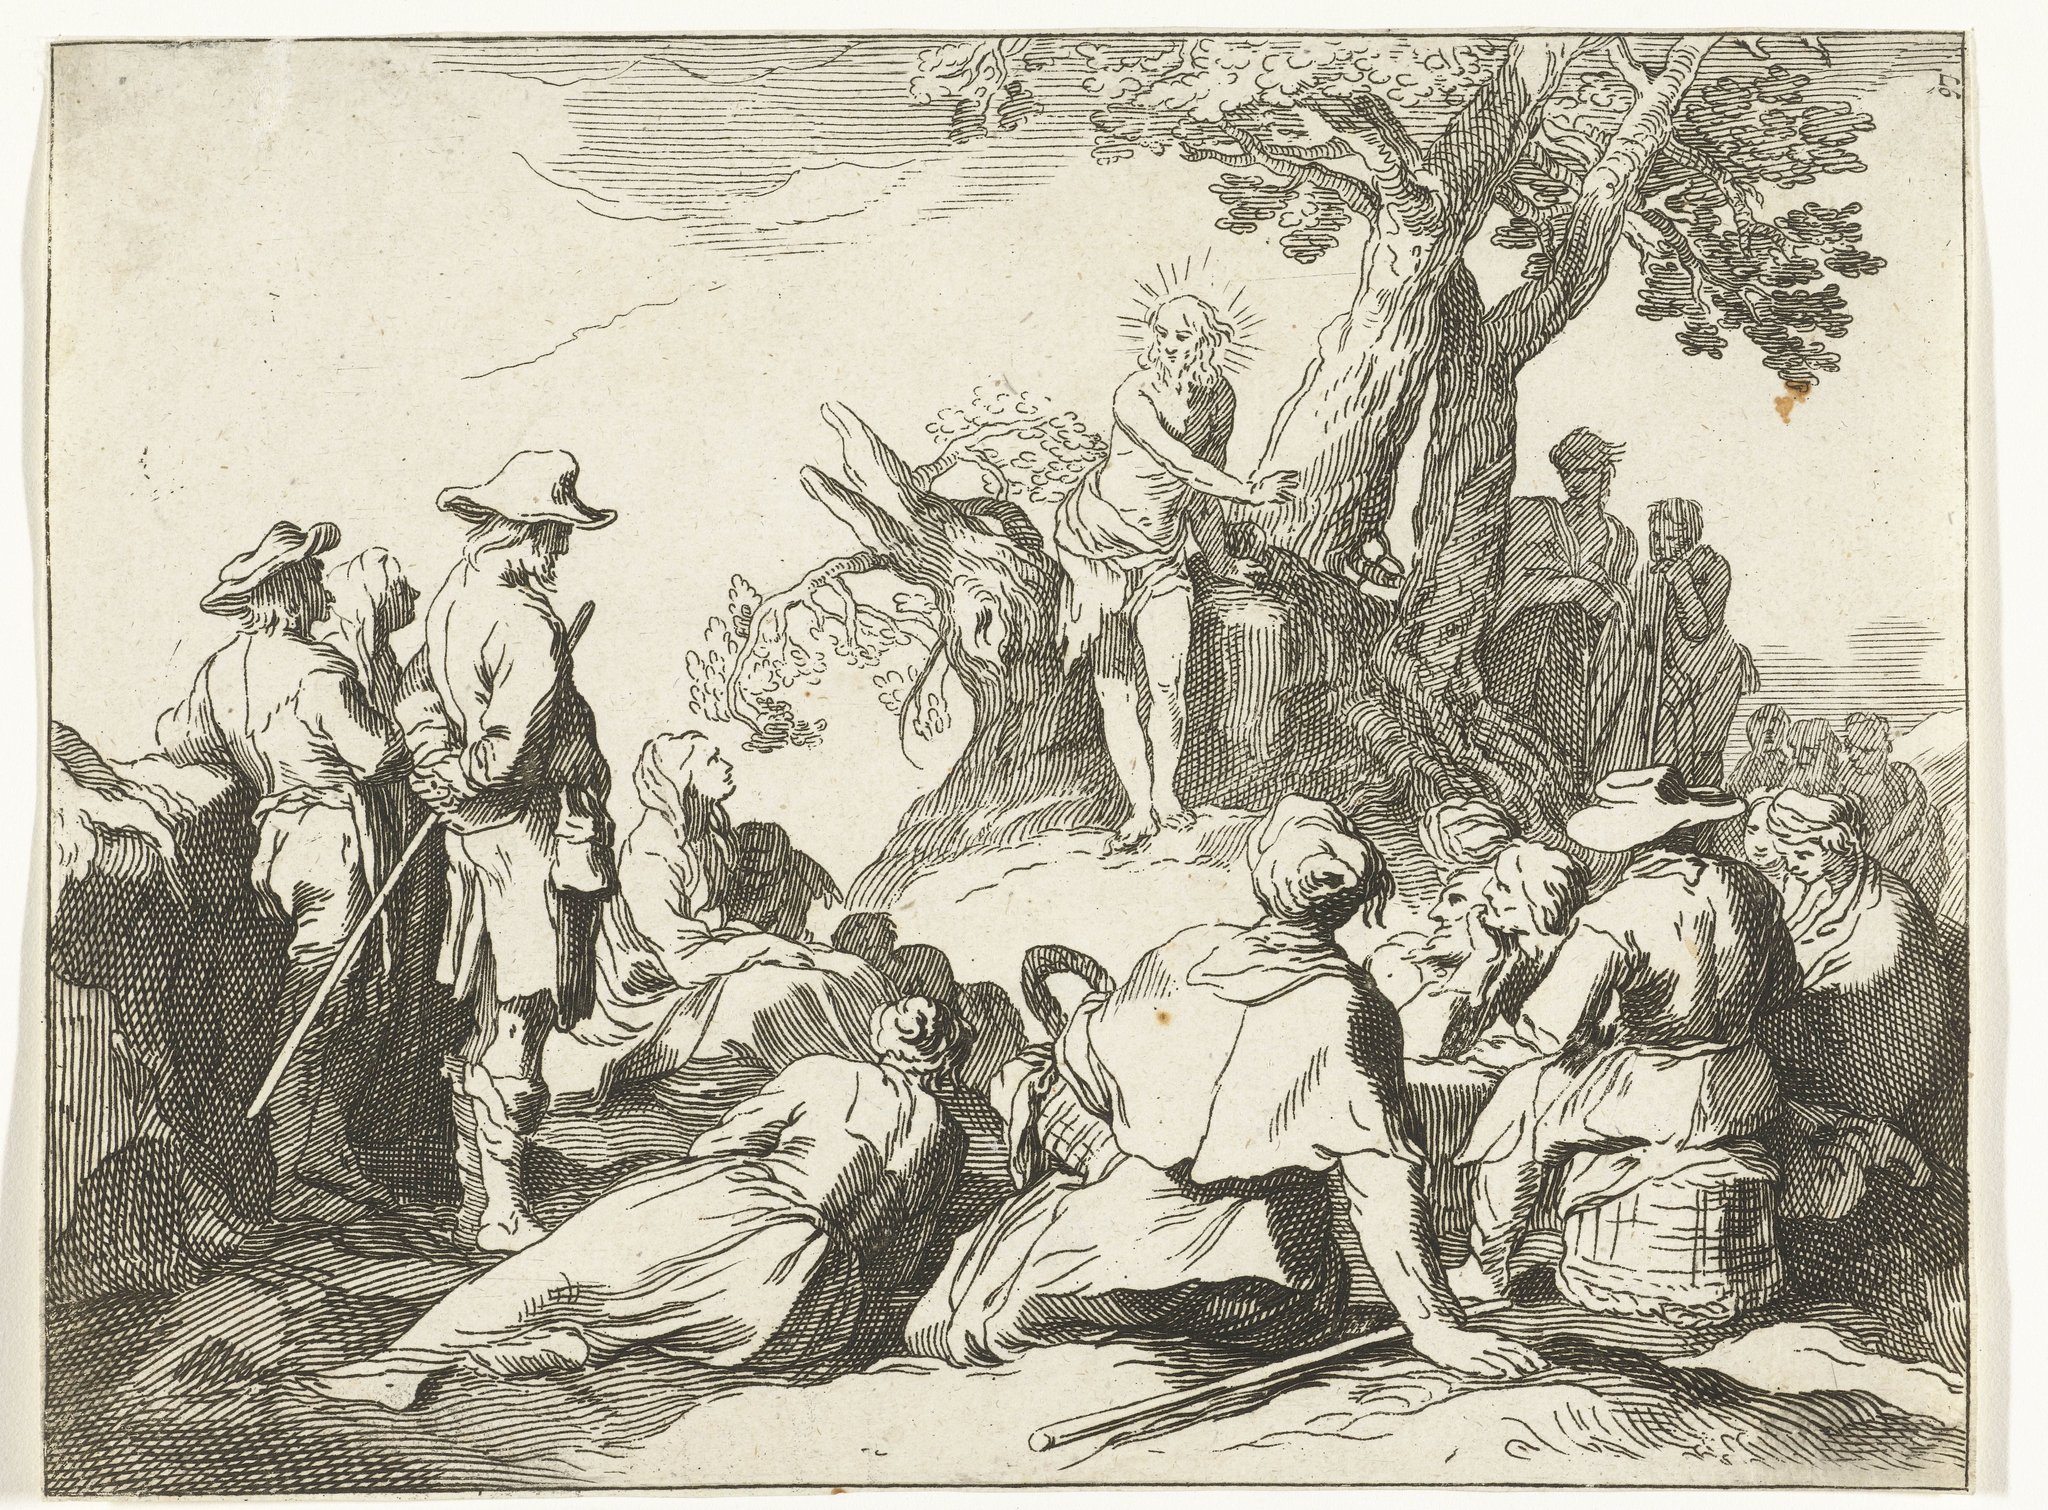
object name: print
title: Prediking van Johannes de Doper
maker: Anonymous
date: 1650-1750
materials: paper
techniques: engraving, etching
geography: netherlands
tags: john the baptist preaching (perhaps christ among the bystanders)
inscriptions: collector's mark: Lugt 2228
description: Johannes de Doper spreekt de menigte toe. Hij staat naast een boom op een verhoging. Het volk zit, ligt of staat in een cirkel om hem heen. Kopie naar een voorstelling uit het tekenboek van Abraham Bloemaert.